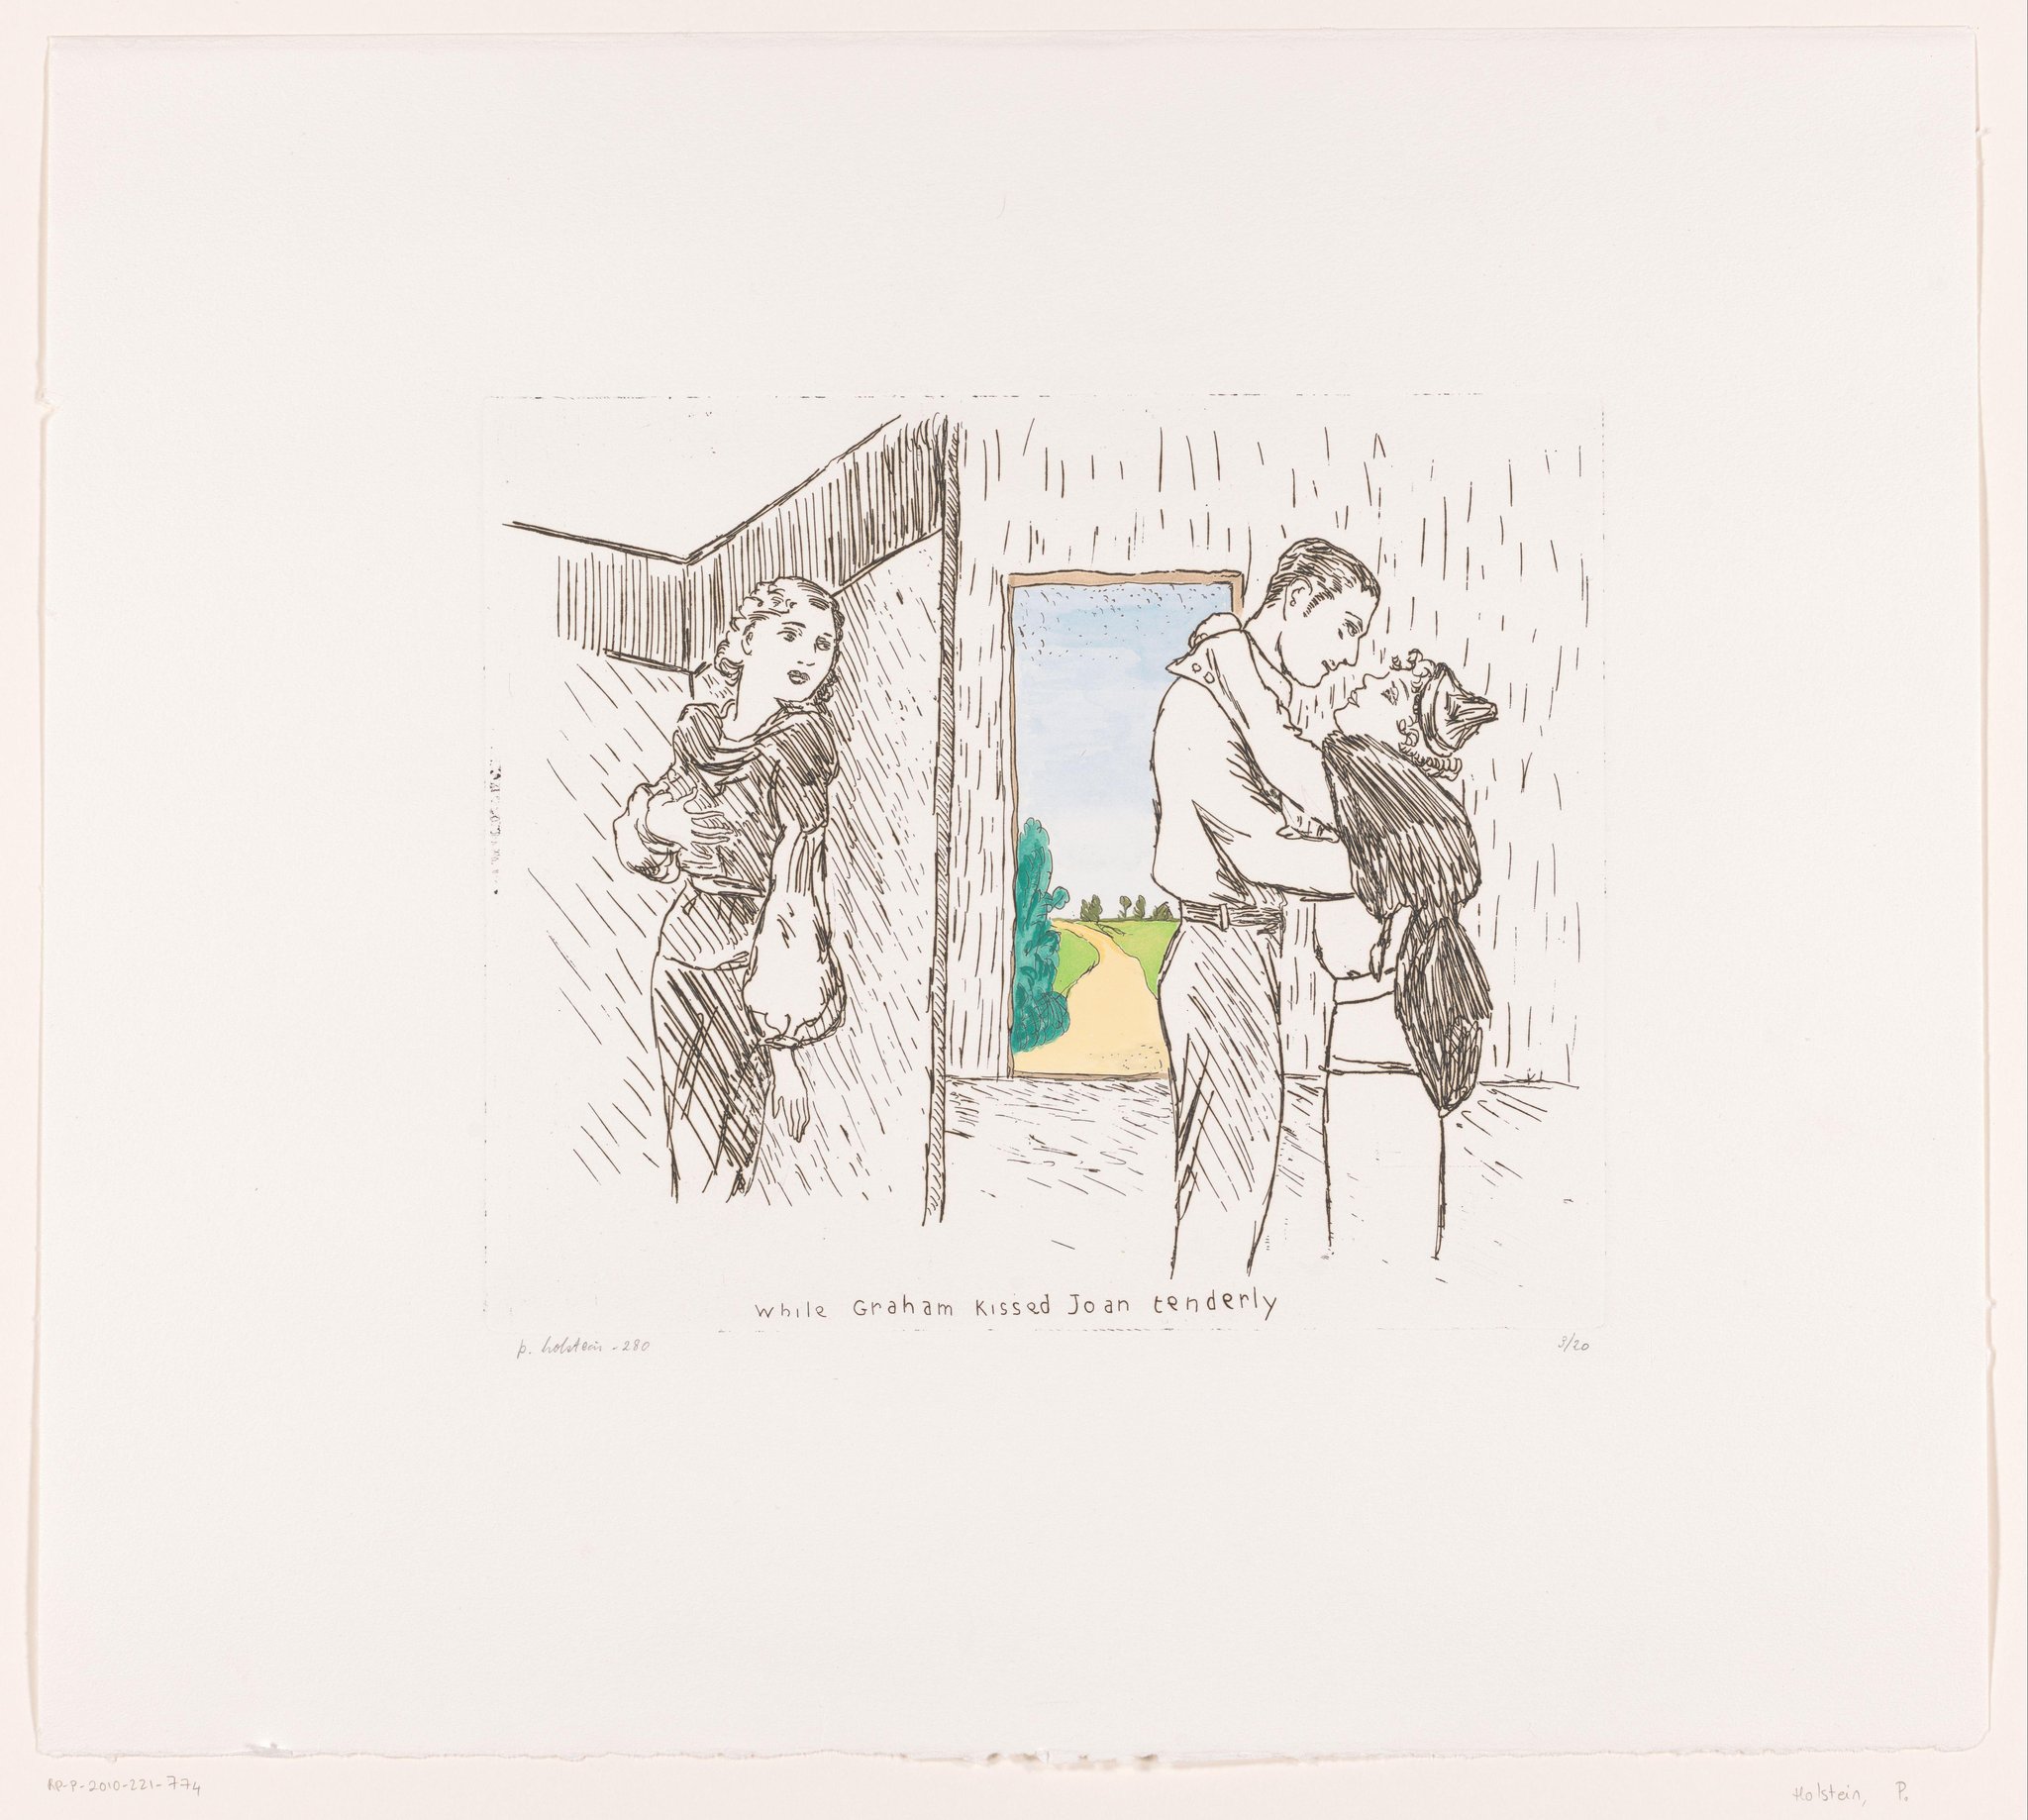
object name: print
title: While Graham Kissed Joan Tenderly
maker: pieter holstein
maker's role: draughtsman, painter, print maker, sculptor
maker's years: 1934-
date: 1975-1984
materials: paper, watercolor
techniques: brush, etching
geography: amsterdam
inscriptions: signature: ‘p. holstein’, inscription: ‘280’, title: ‘WHILE GRAHAM KISSED JOAN TENDERLY’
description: Zoenend paar en toekijkende vrouw met hand op haar buik.